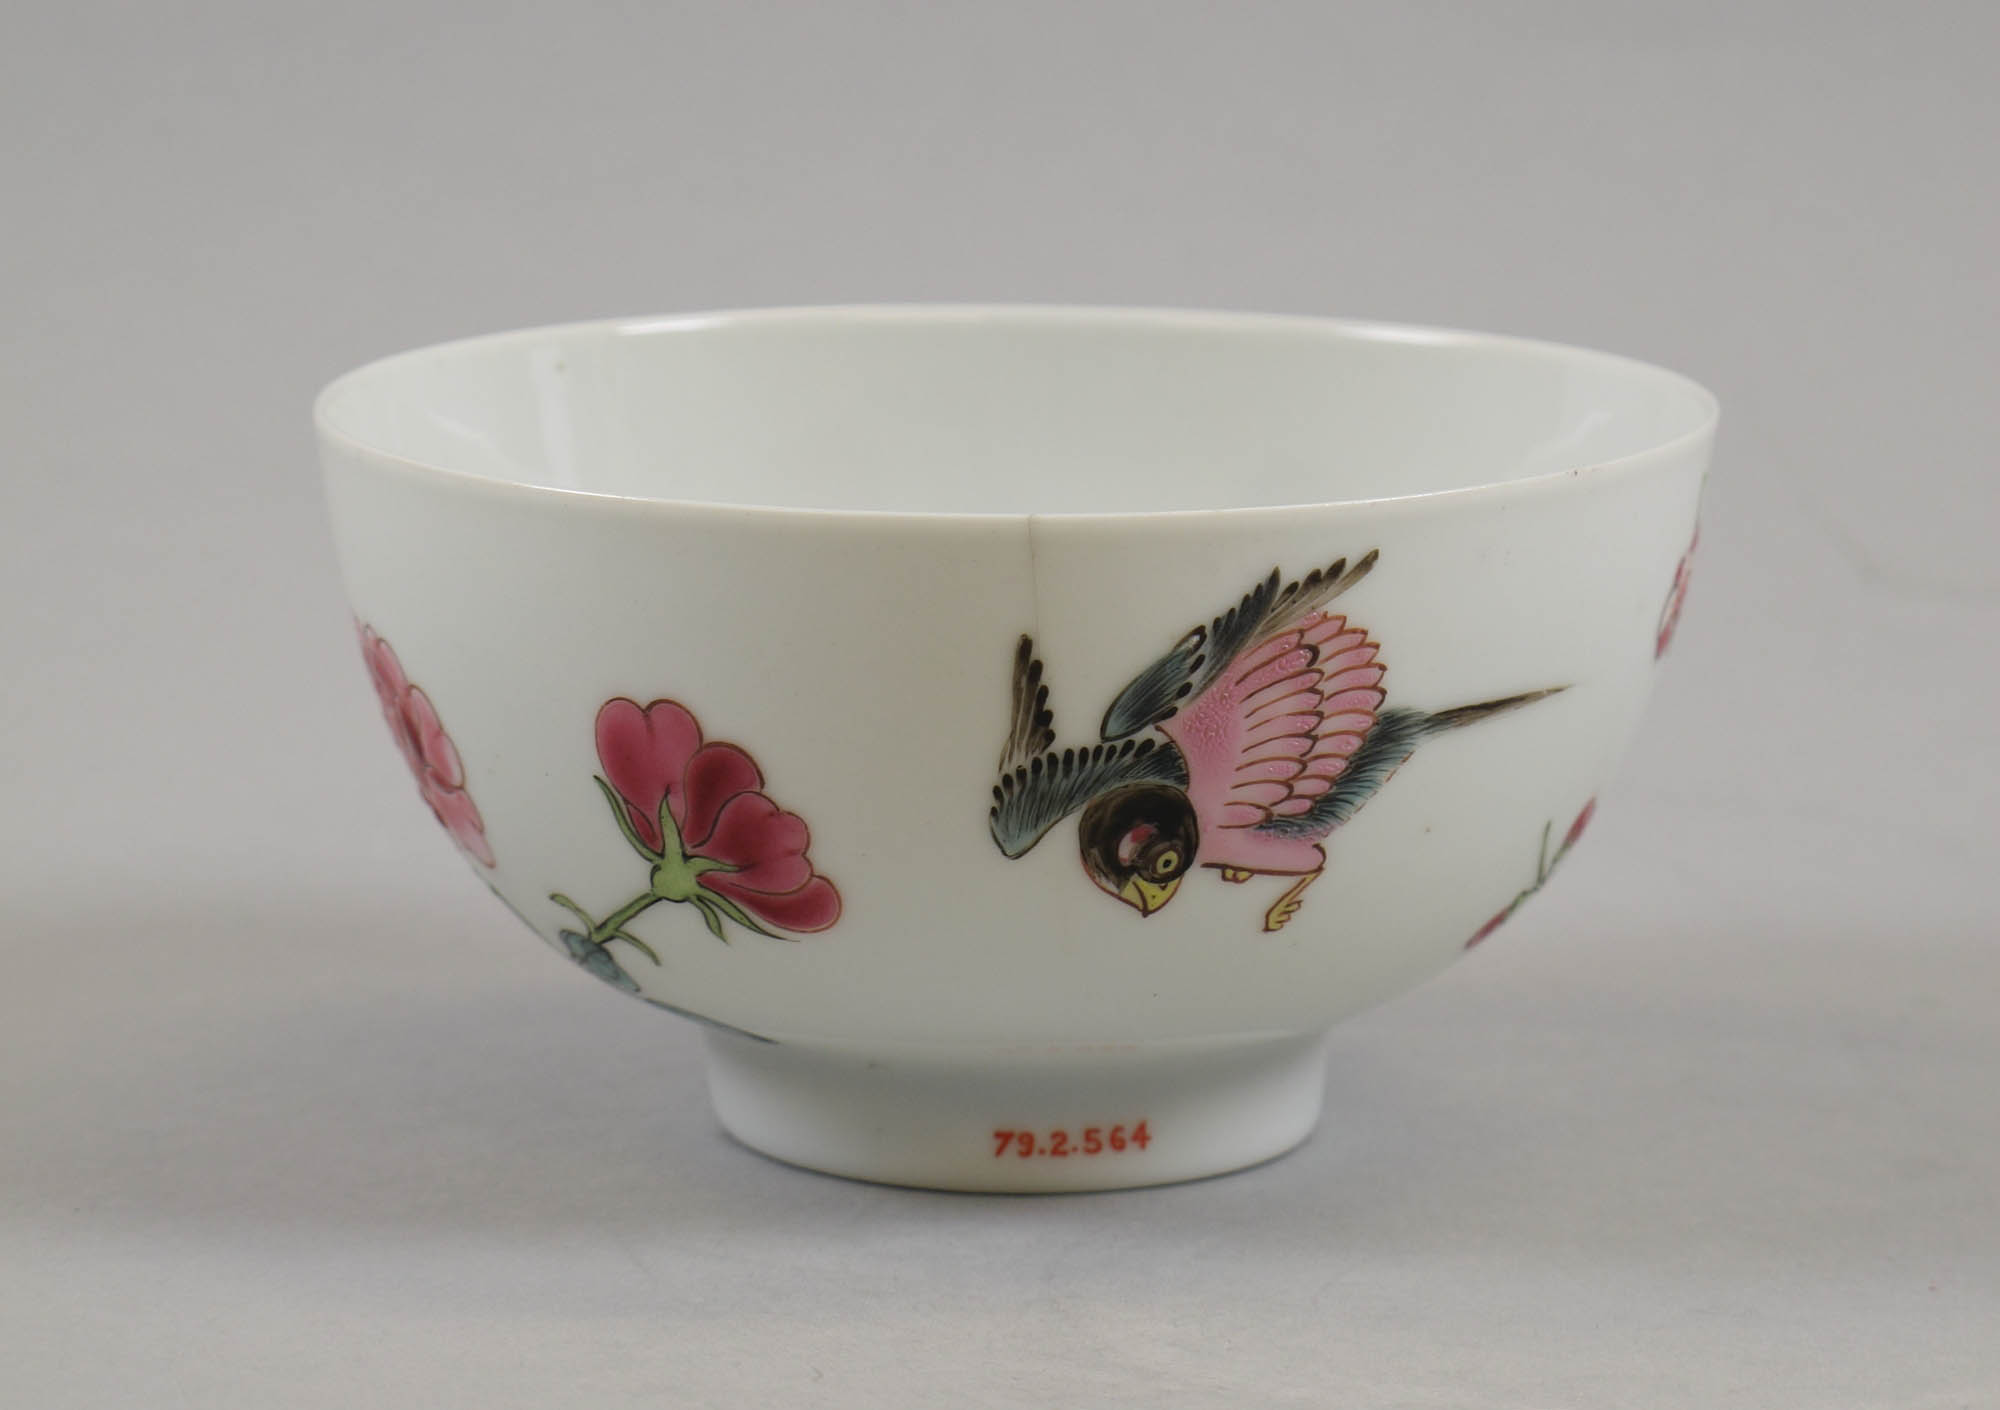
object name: cup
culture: chinese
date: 1701-1750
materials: enamel, porcelain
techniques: overglaze, painting, polychrome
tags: birds,flowers